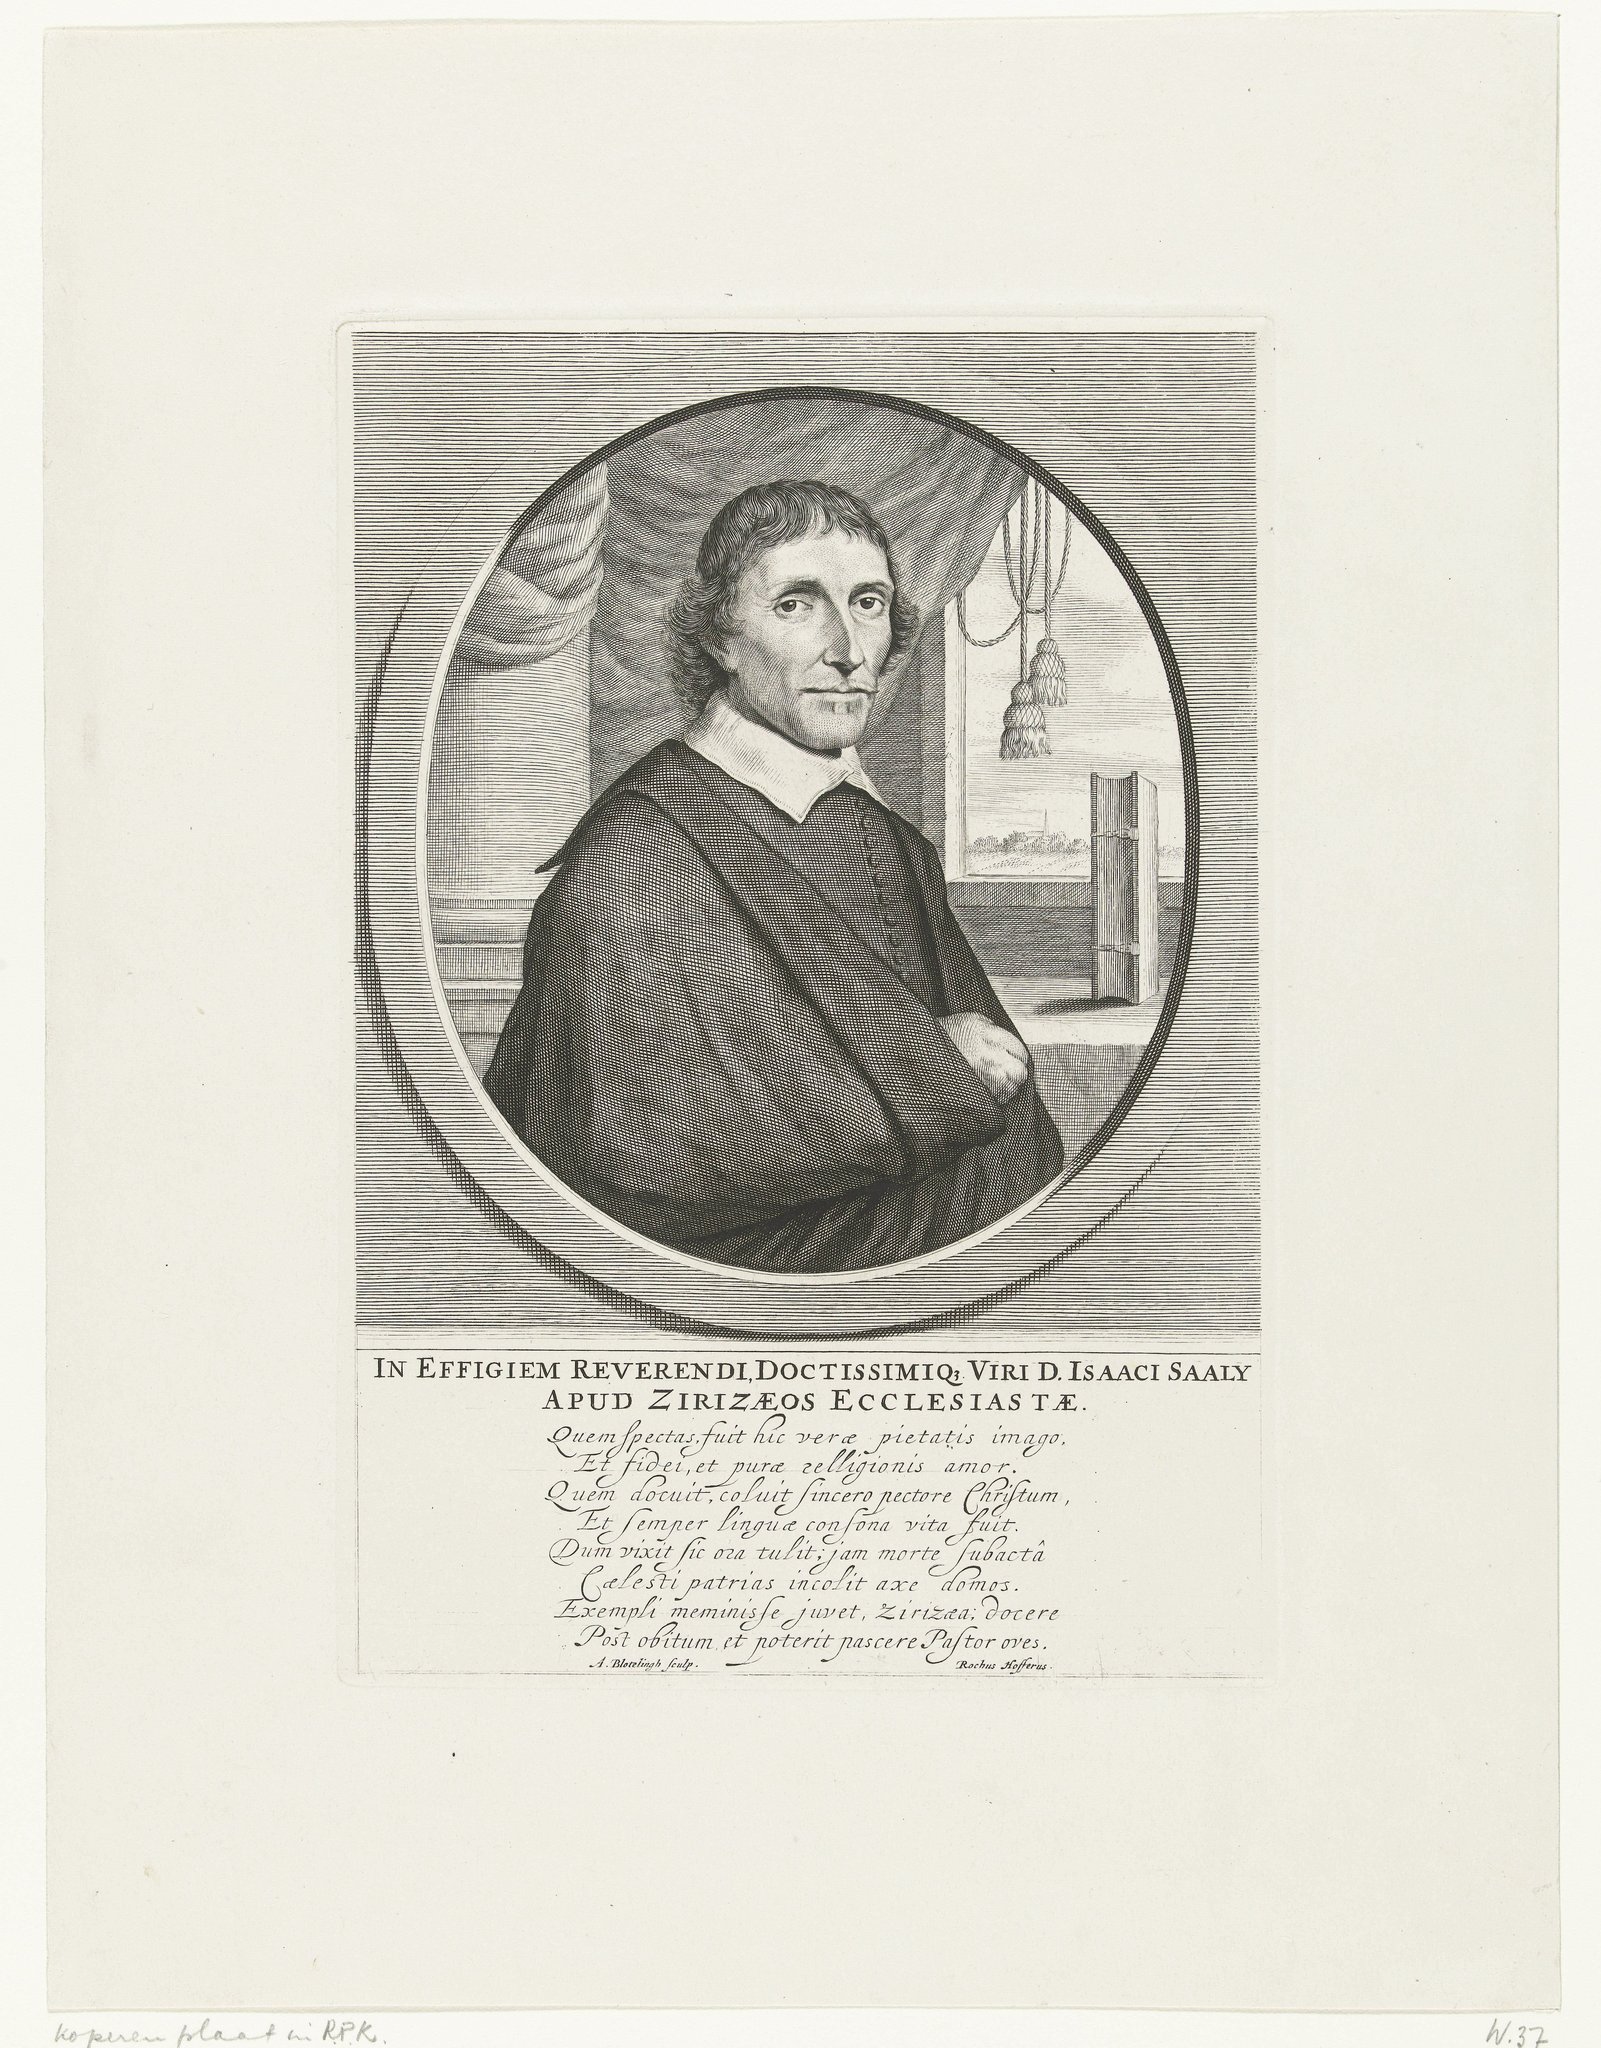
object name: print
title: Portret van Isaac Saaly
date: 1655-1669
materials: paper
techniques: engraving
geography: amsterdam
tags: functionaries and dignitaries (with name) ~ episcopal protestant churches, theologian, historical persons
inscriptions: collector's mark: Lugt 2228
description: Portret van Isaac Saaly (ook bekend als Isaac Sael), van 1653 tot 1669 predikant te Zierikzee. Naast hem voor het raam een bijbel. Onder het portret een Latijns vers van Rochus Hofferus.